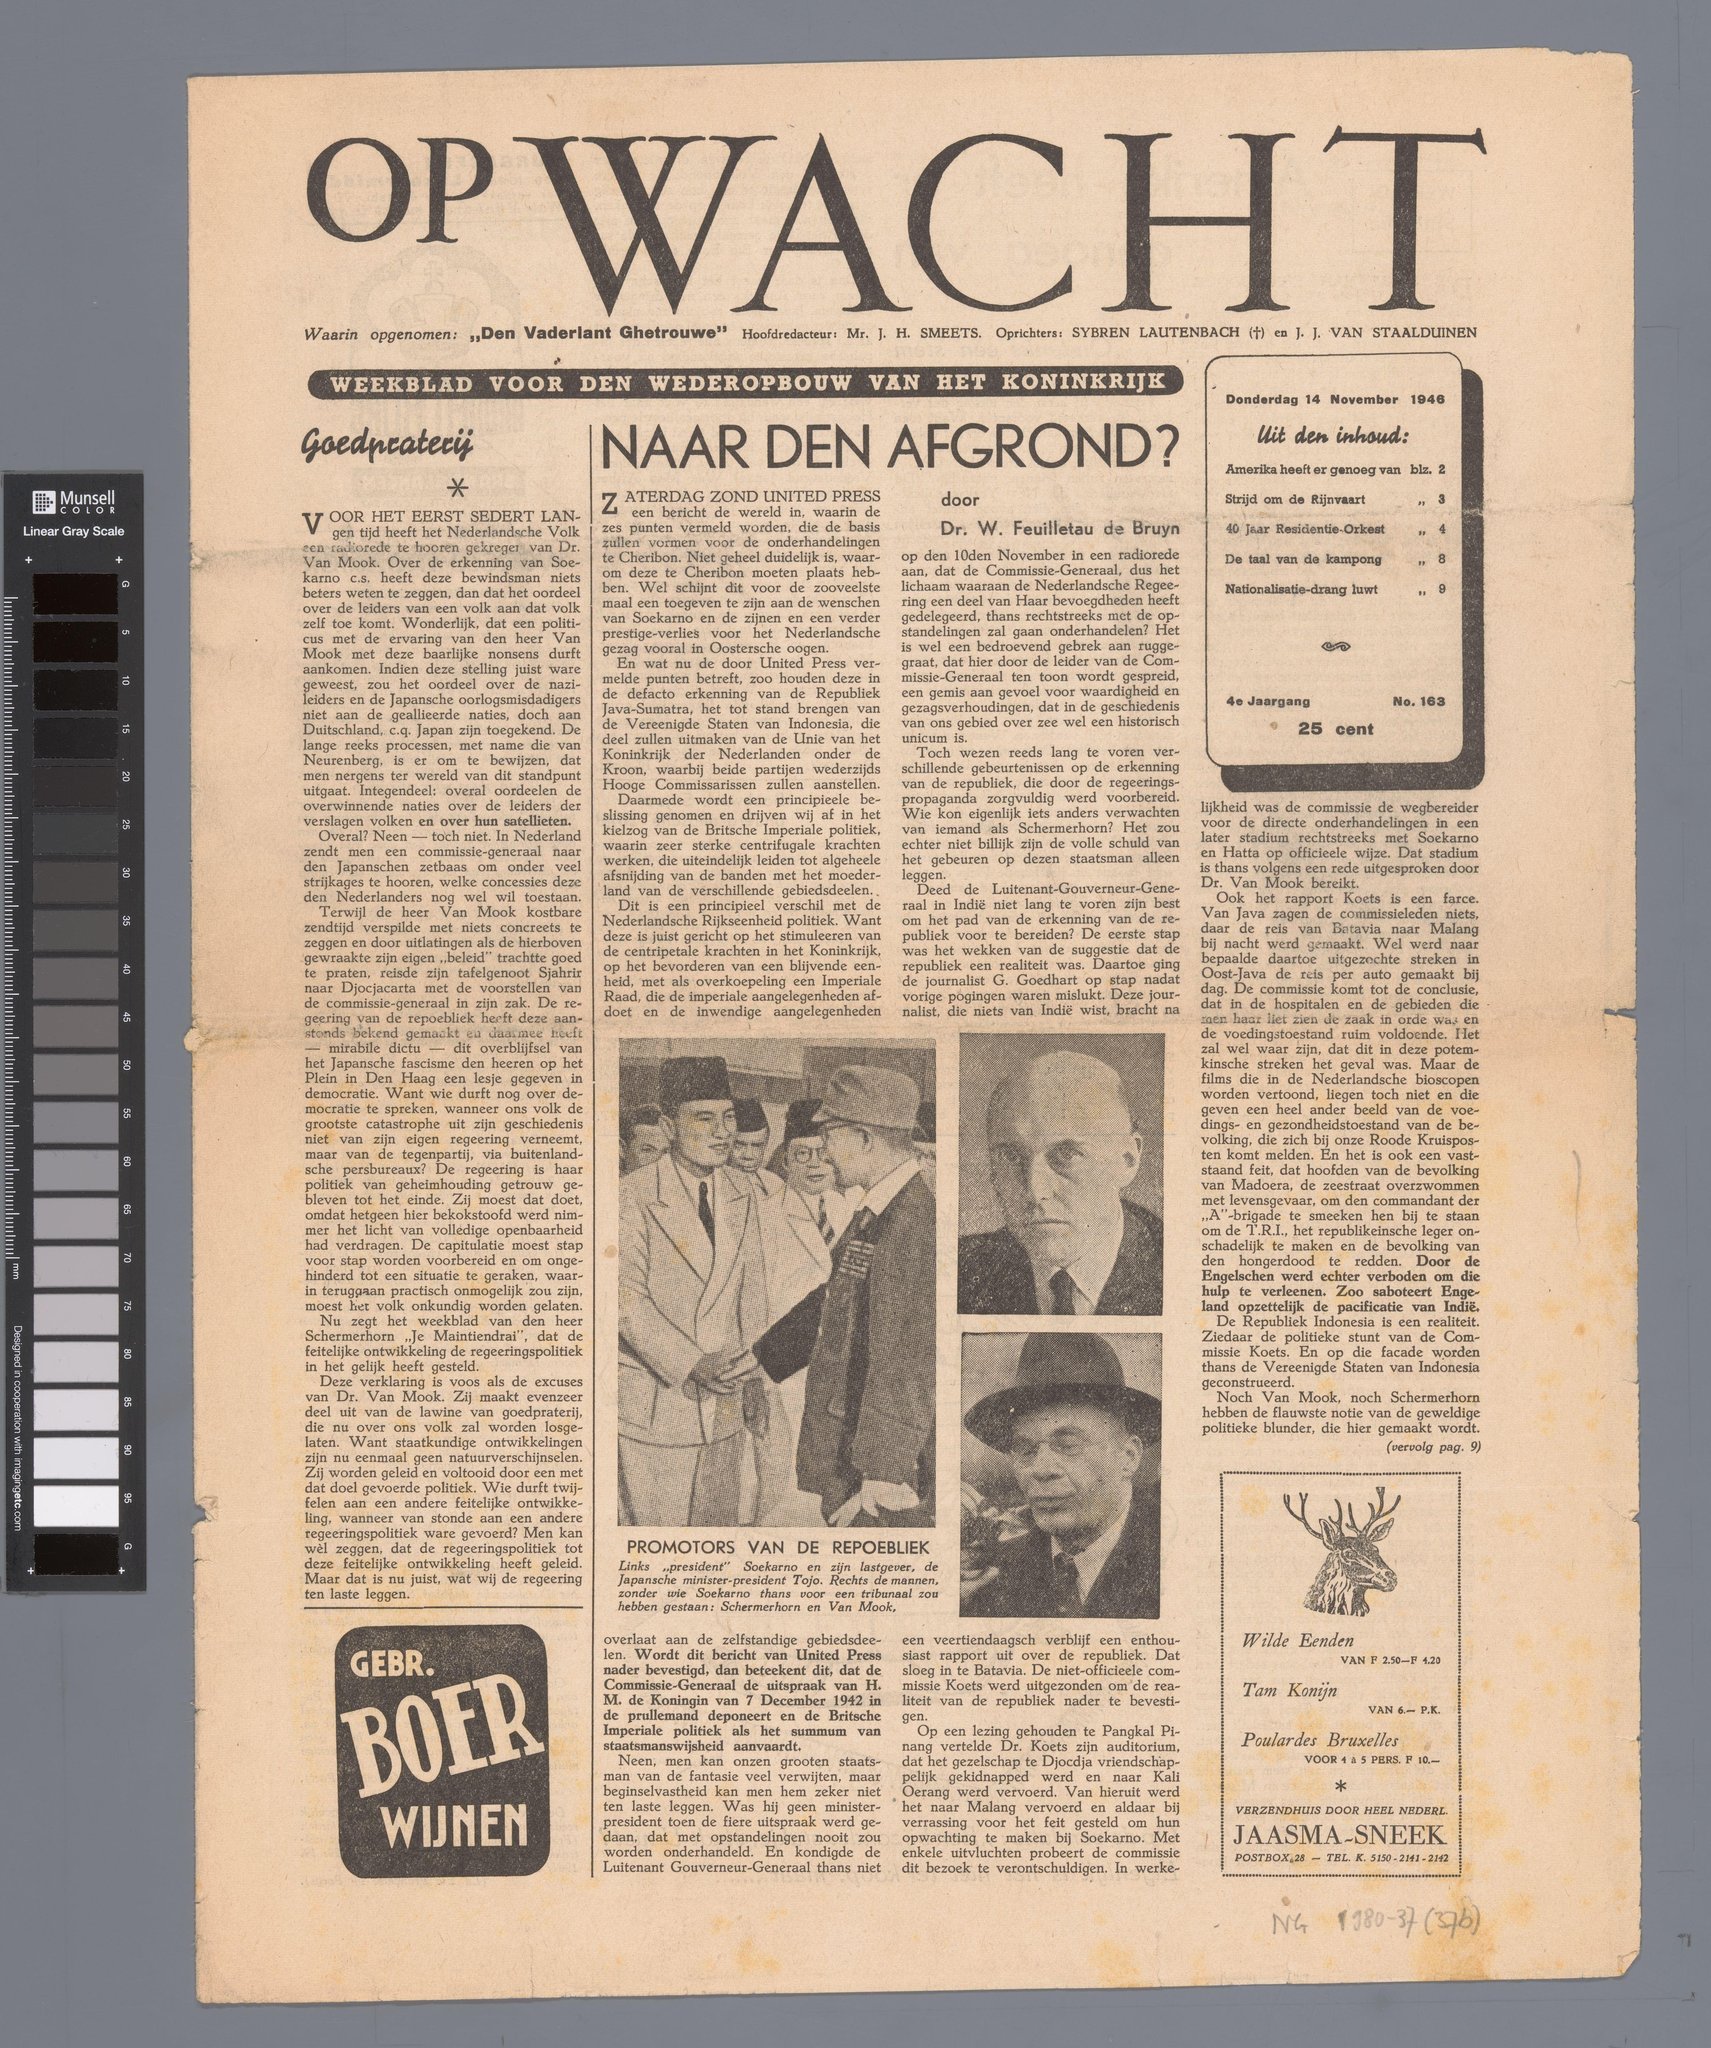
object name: newspaper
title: Op wacht; weekblad voor den wederopbouw van het Koninkrijk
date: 1946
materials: paper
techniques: printing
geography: the hague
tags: indonesia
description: Krant, nr. 163 van 'Op wacht' 4e jaargang, 4 (van 10) pp, met artikelen gericht tegen een eventuele onafhankelijkheid van Indonesië en tegen de politiek van de Nederlandse regering in deze.